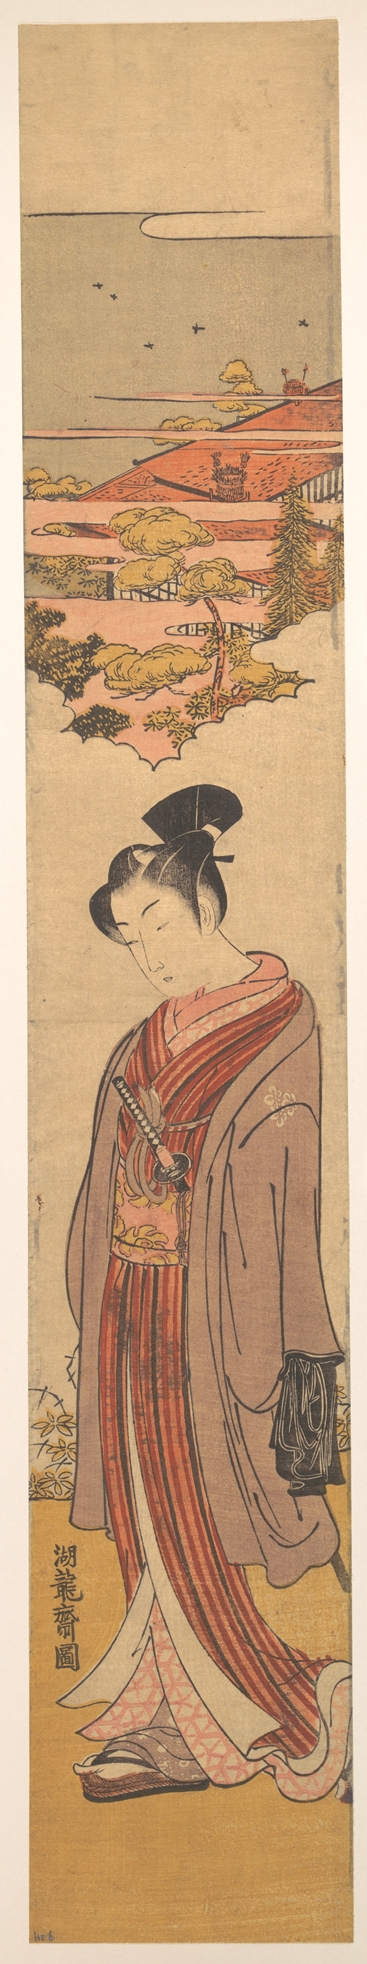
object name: print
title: Young Man Strolling near the Sea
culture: japanese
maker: isoda koryūsai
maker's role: artist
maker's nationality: japanese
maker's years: 1735-1790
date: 1770-1790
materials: ink, paper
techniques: woodblock print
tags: men